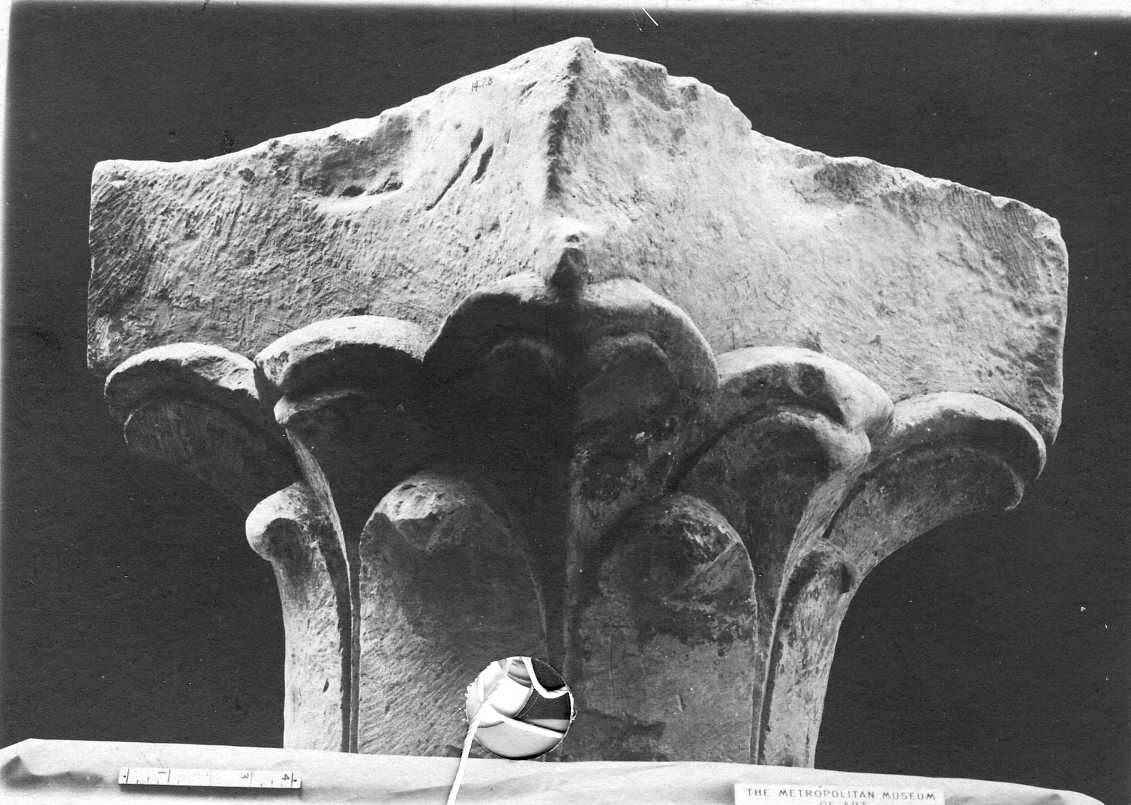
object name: capital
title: Capital from a Reused Pharaonic Block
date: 301-500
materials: limestone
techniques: carving, relief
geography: egypt